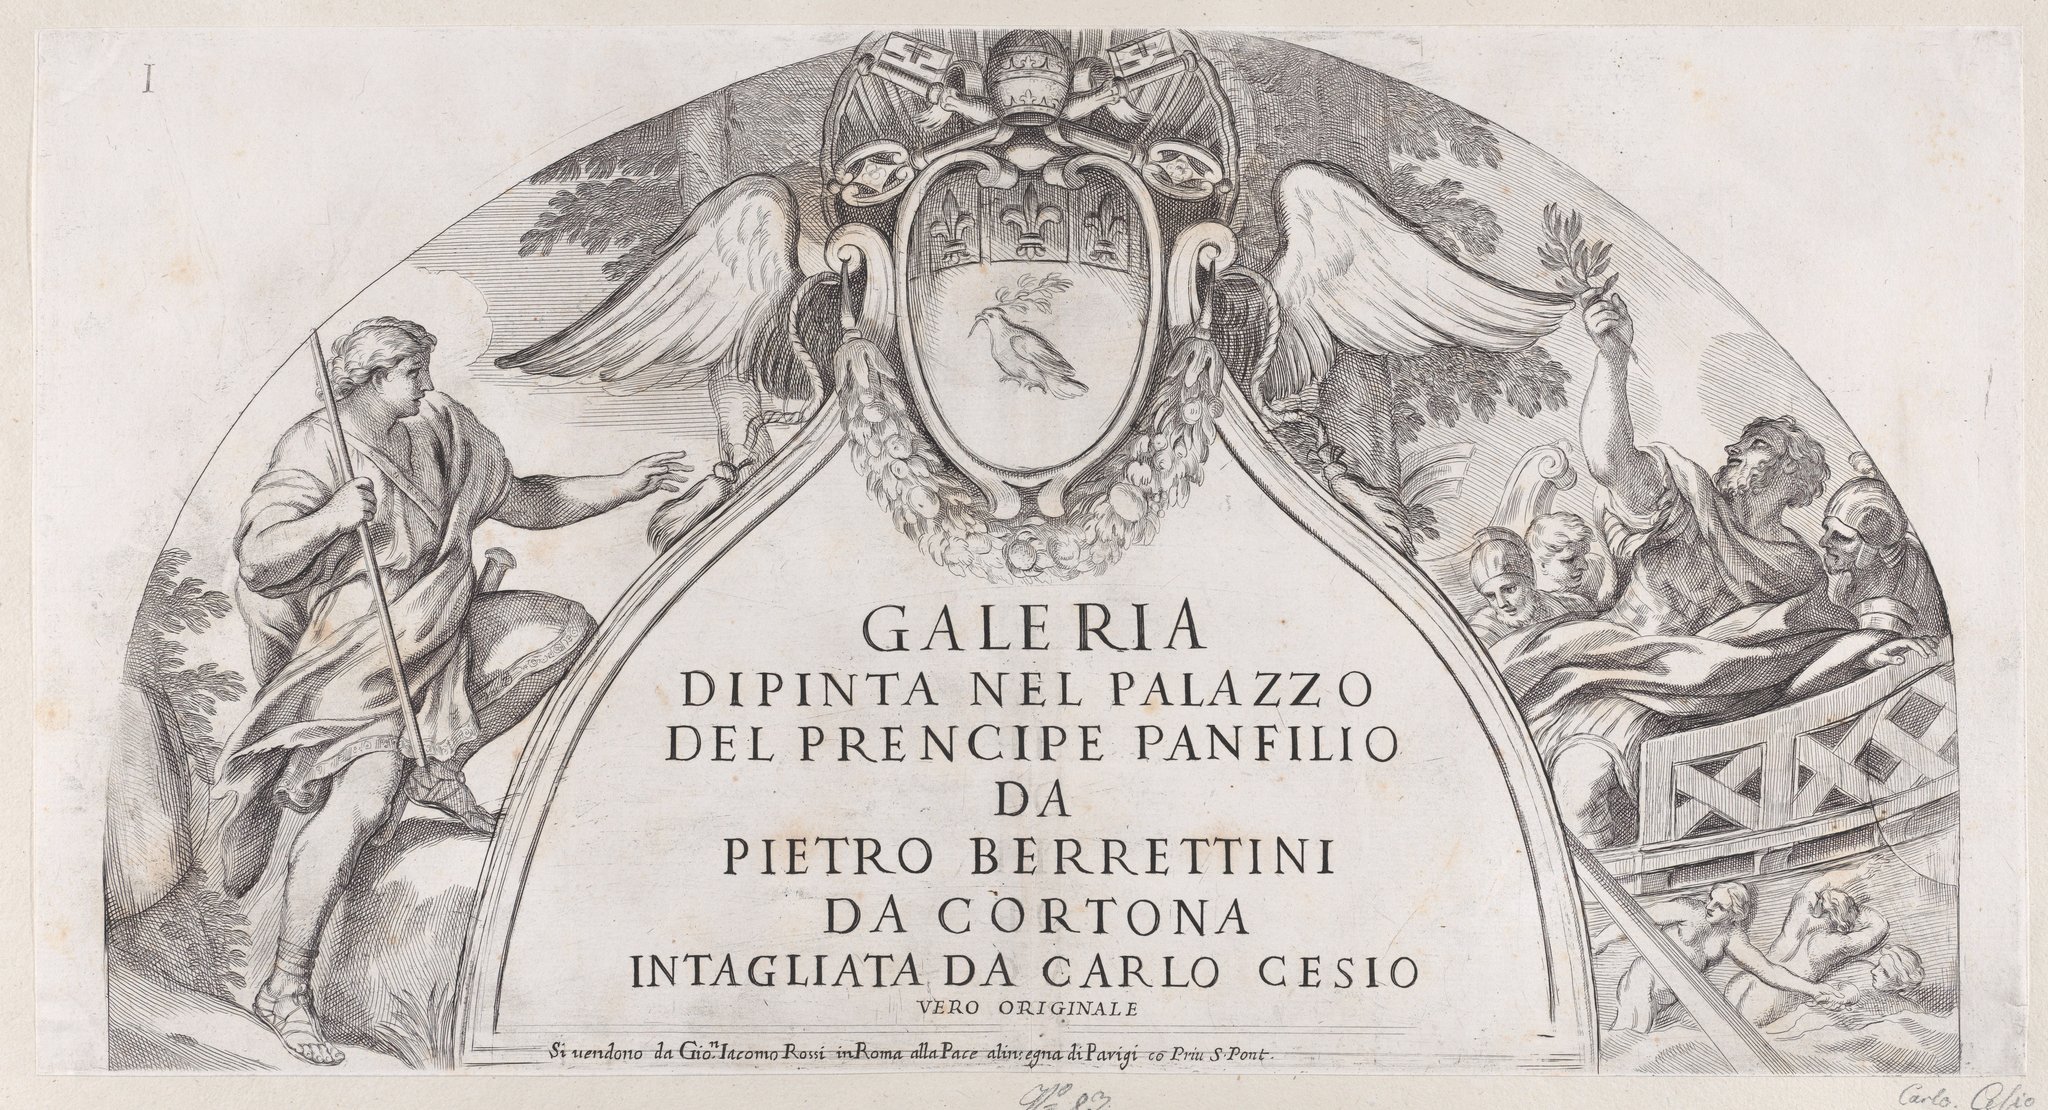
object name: print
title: Title page to "Galleria Dipinta nel Palazzo del Prencipe Panfilio" after the ceiling frescoes by Pietro da Cortona depicting the history of Aeneas in the Palazzo Pamphili, Rome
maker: carlo cesio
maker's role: artist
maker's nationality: italian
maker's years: 1622-1682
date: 1661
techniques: etching